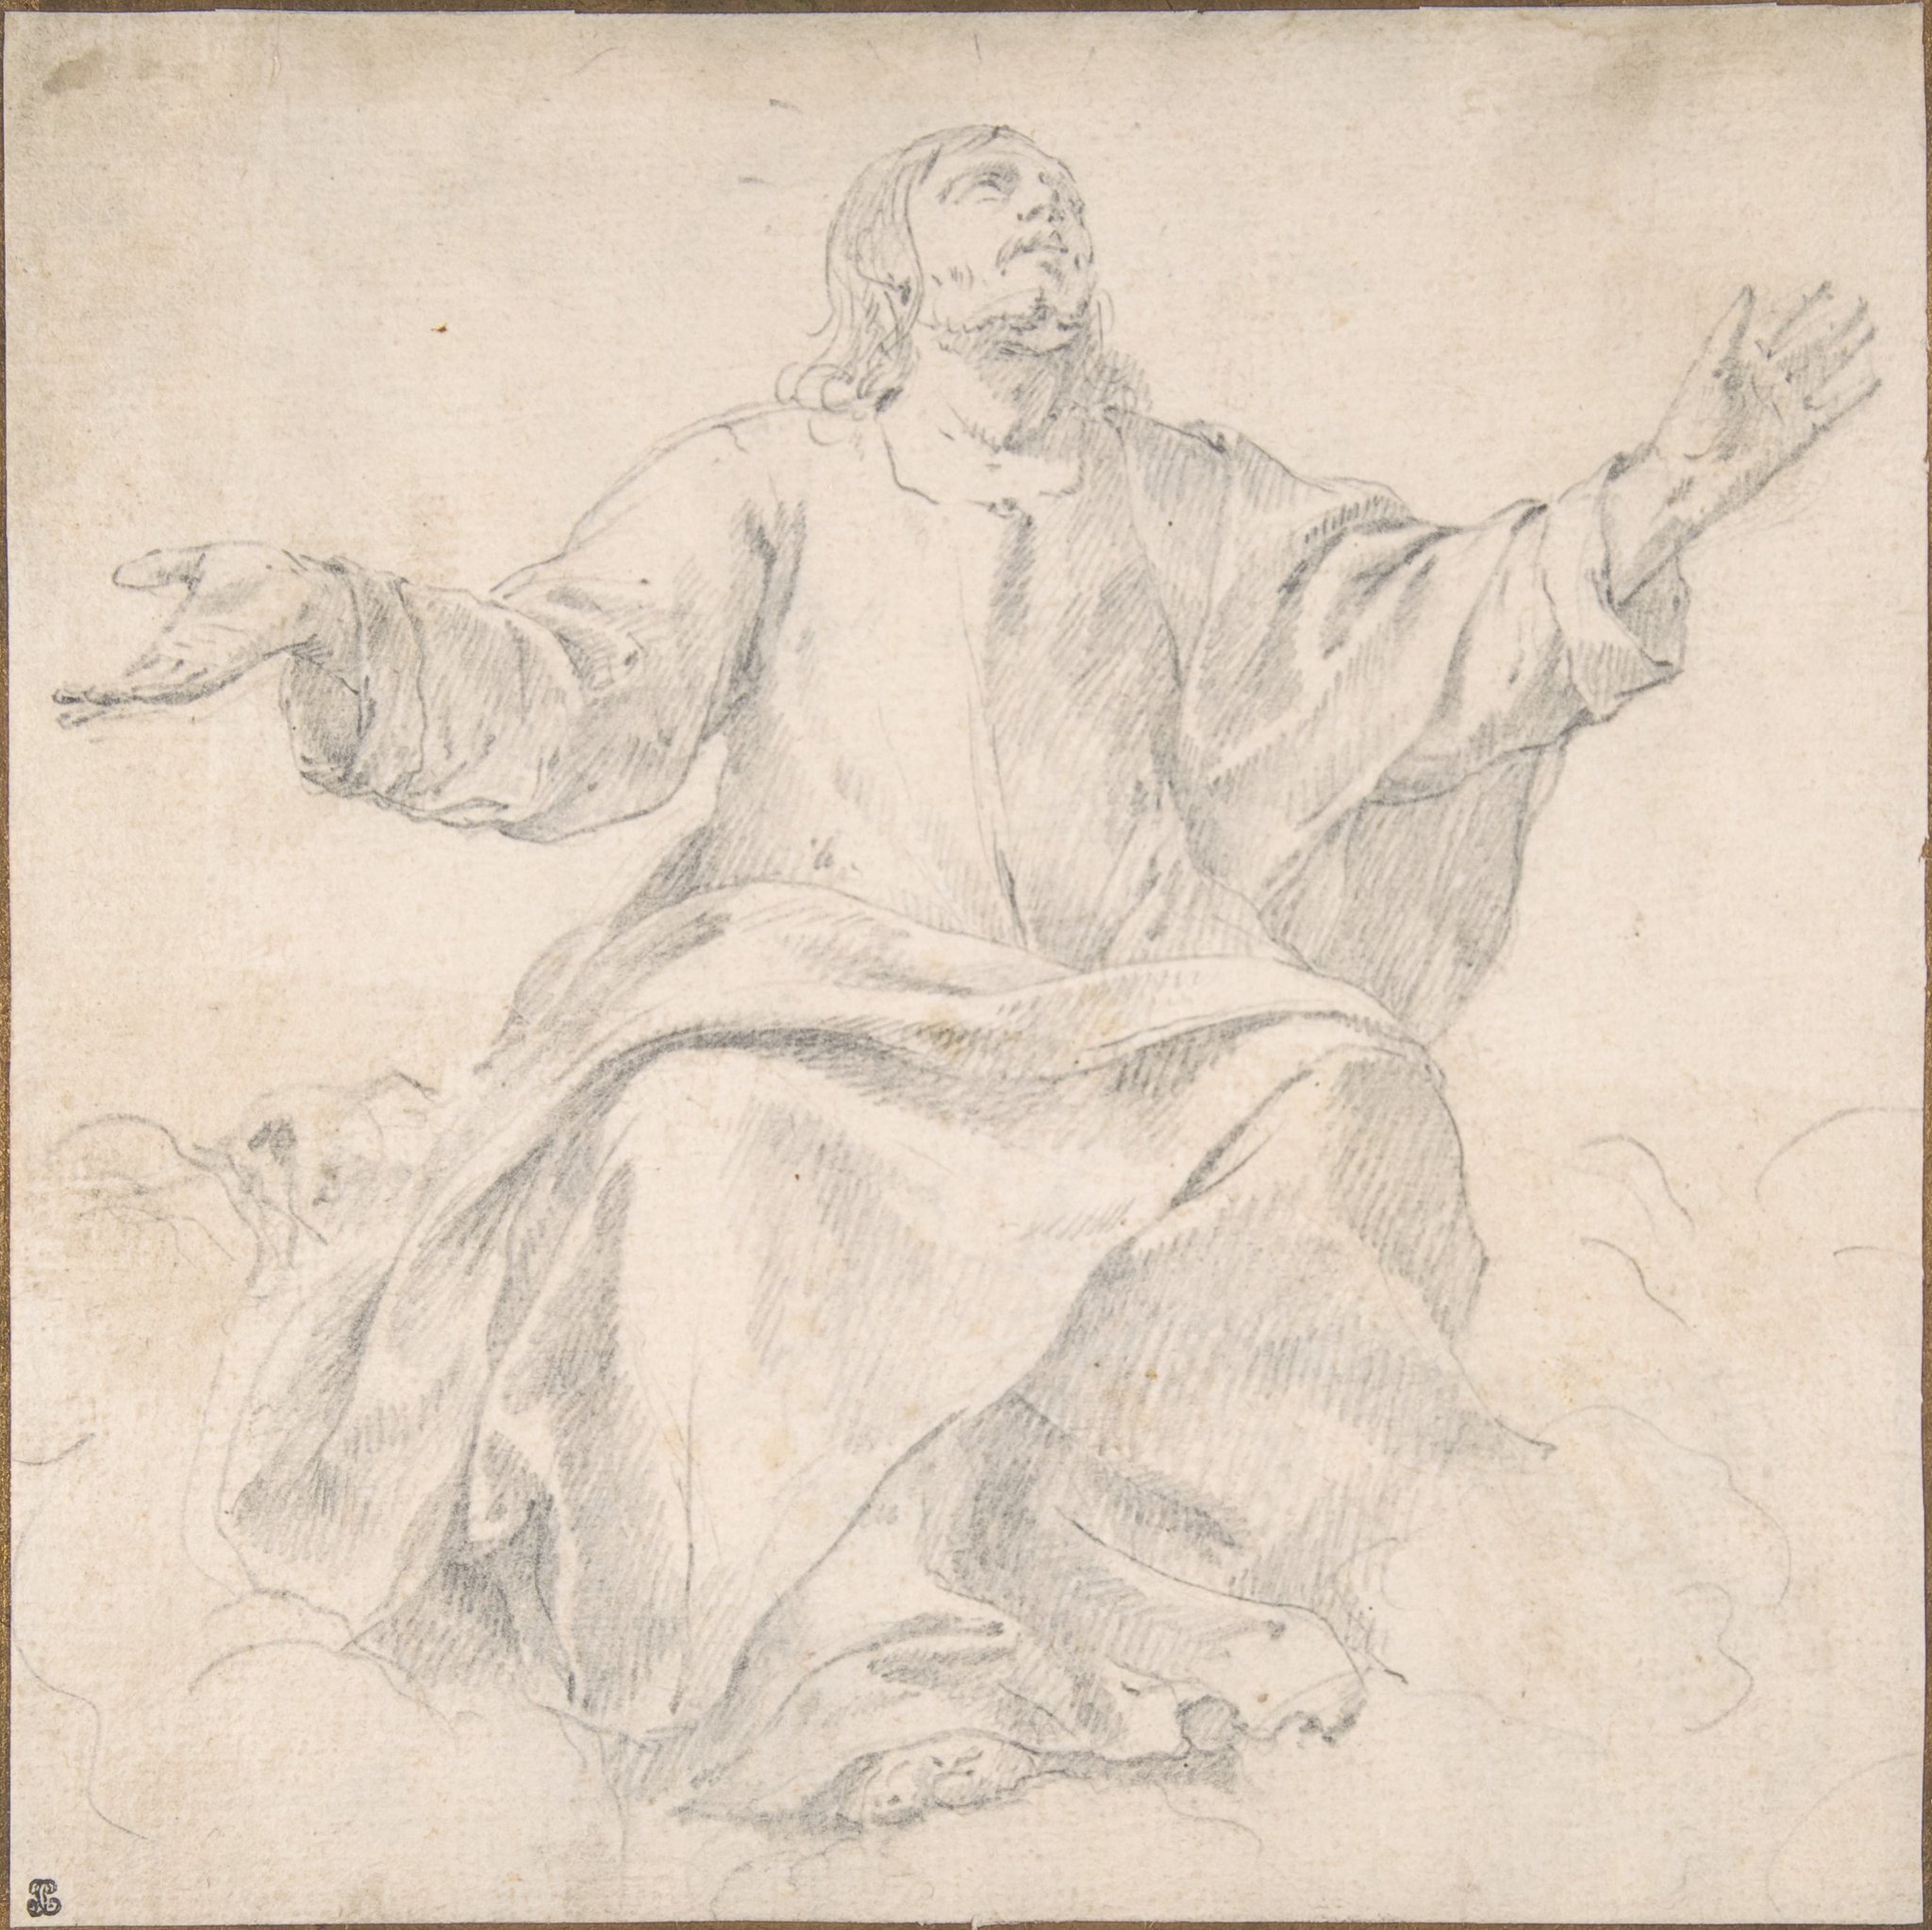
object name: drawing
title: Study for Christ as Mediator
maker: jean daret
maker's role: artist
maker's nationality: french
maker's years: 1613-1668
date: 1620-1670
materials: graphite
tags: christ